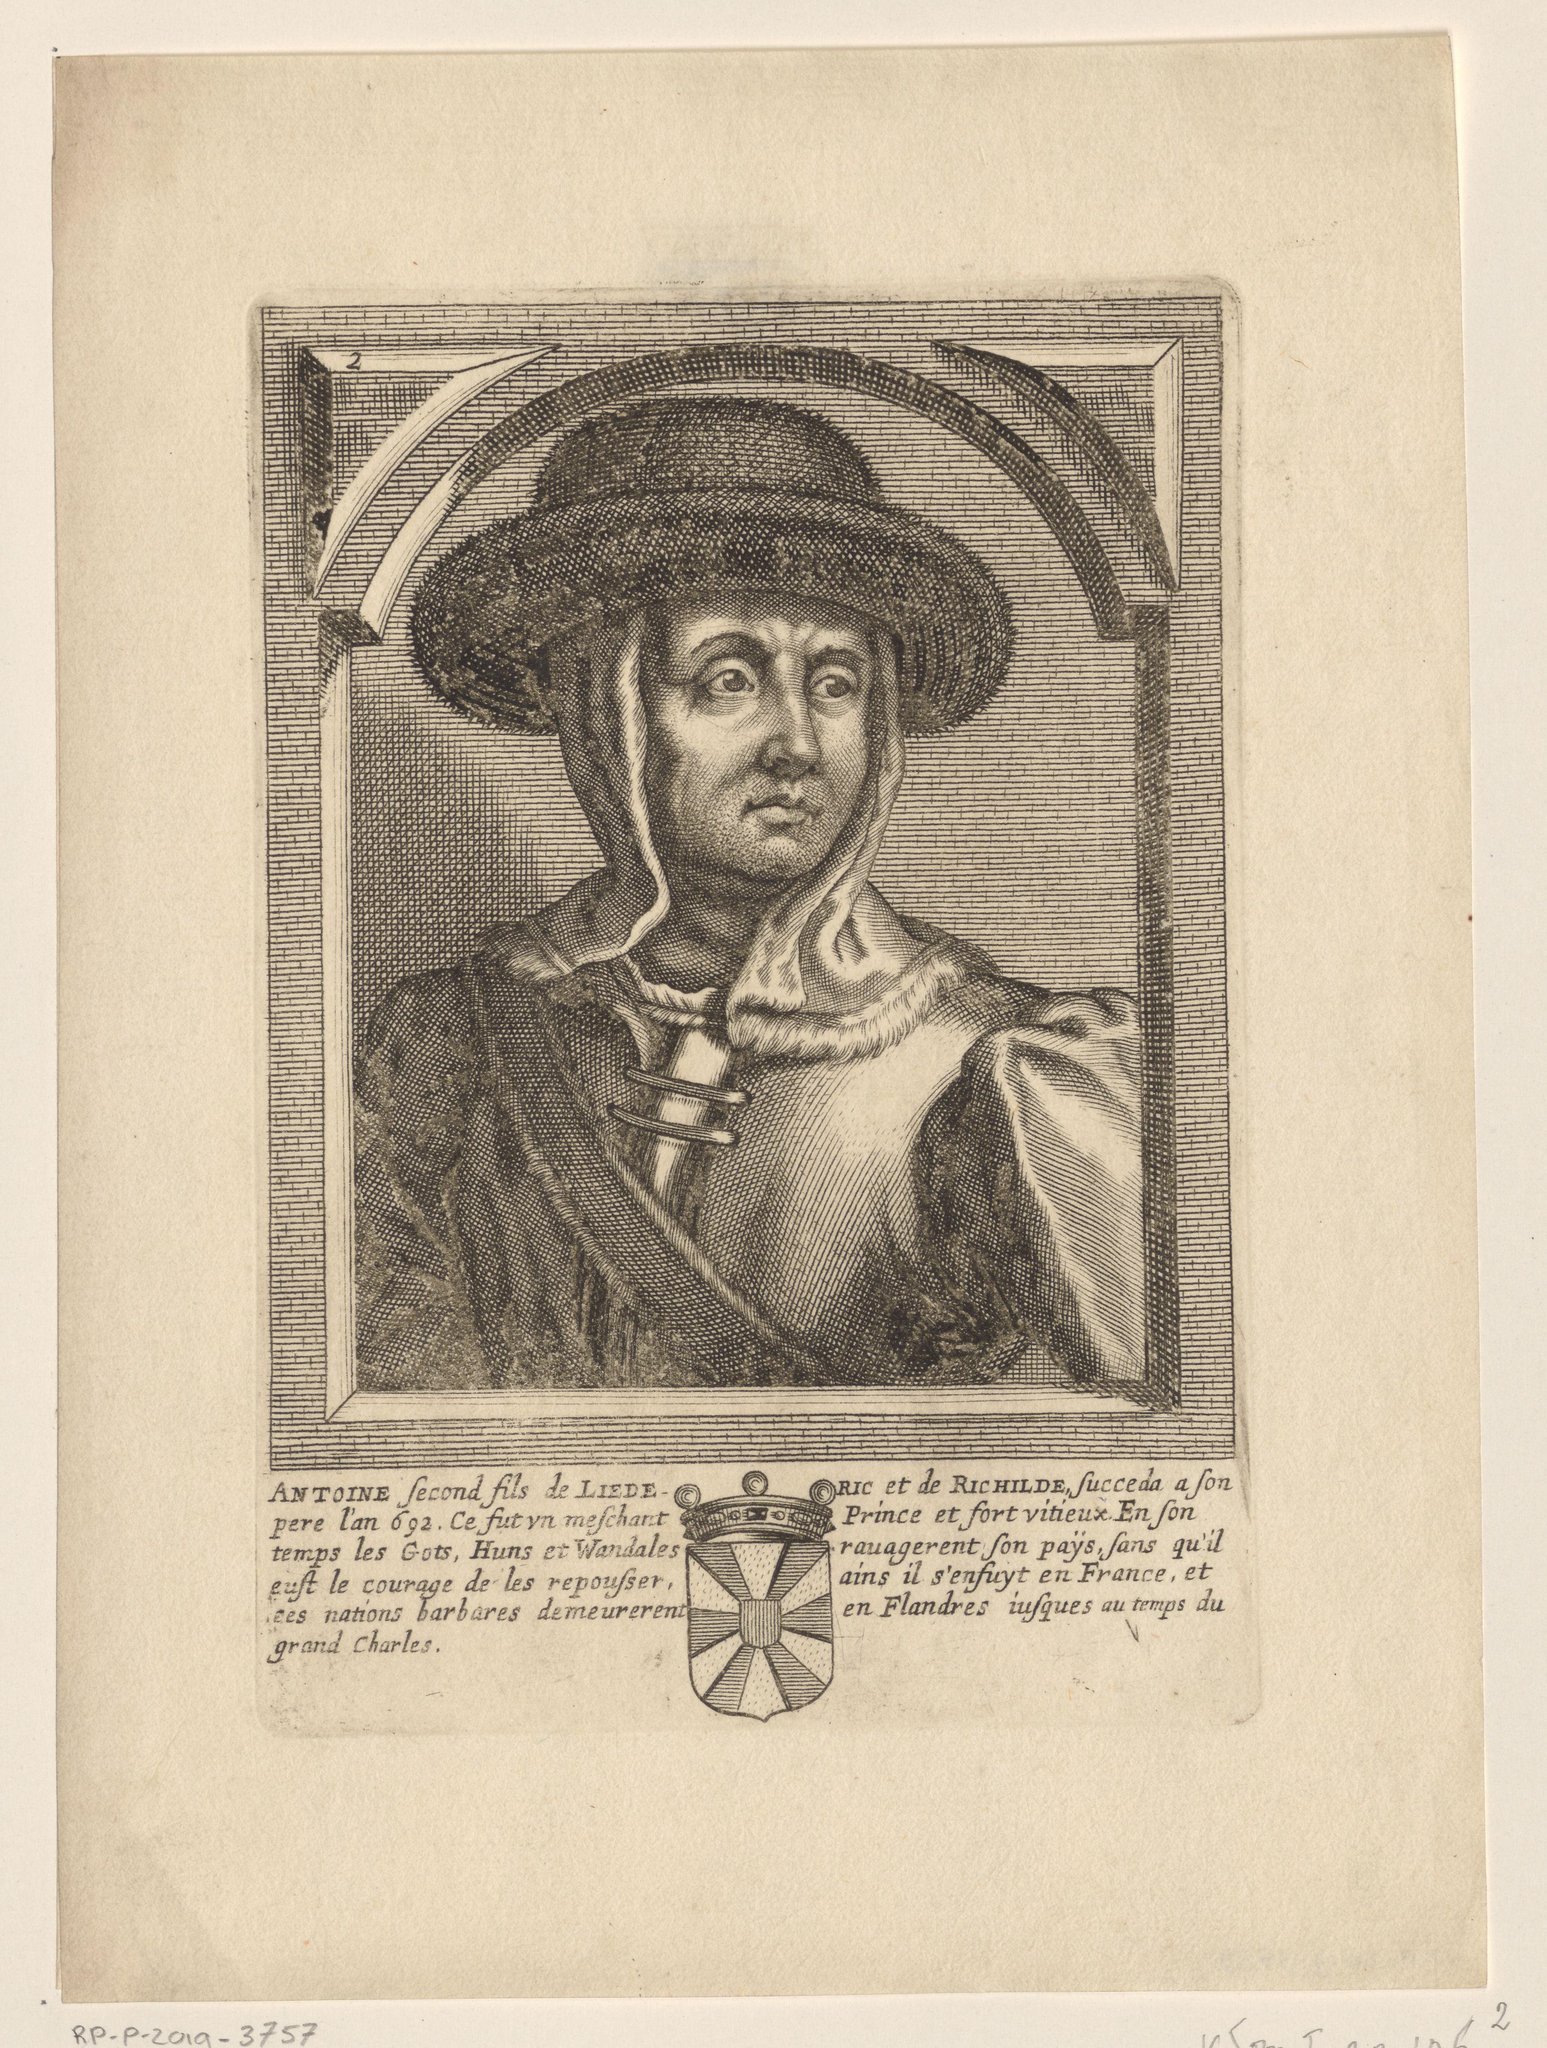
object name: print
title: Portretten van de graven van Vlaanderen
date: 1663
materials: paper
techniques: engraving, etching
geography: antwerp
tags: historical persons, armorial bearing, heraldry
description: Met midden onder zijn wapenschild. Linksboven genummerd: 2.